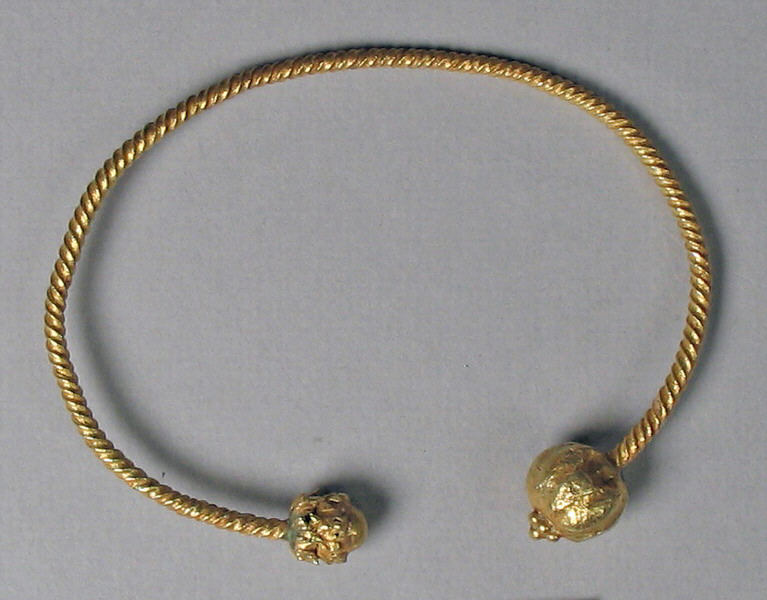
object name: bracelet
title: Bracelet, Twisted Wire and Foliate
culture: indonesian, central java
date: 701-1200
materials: gold